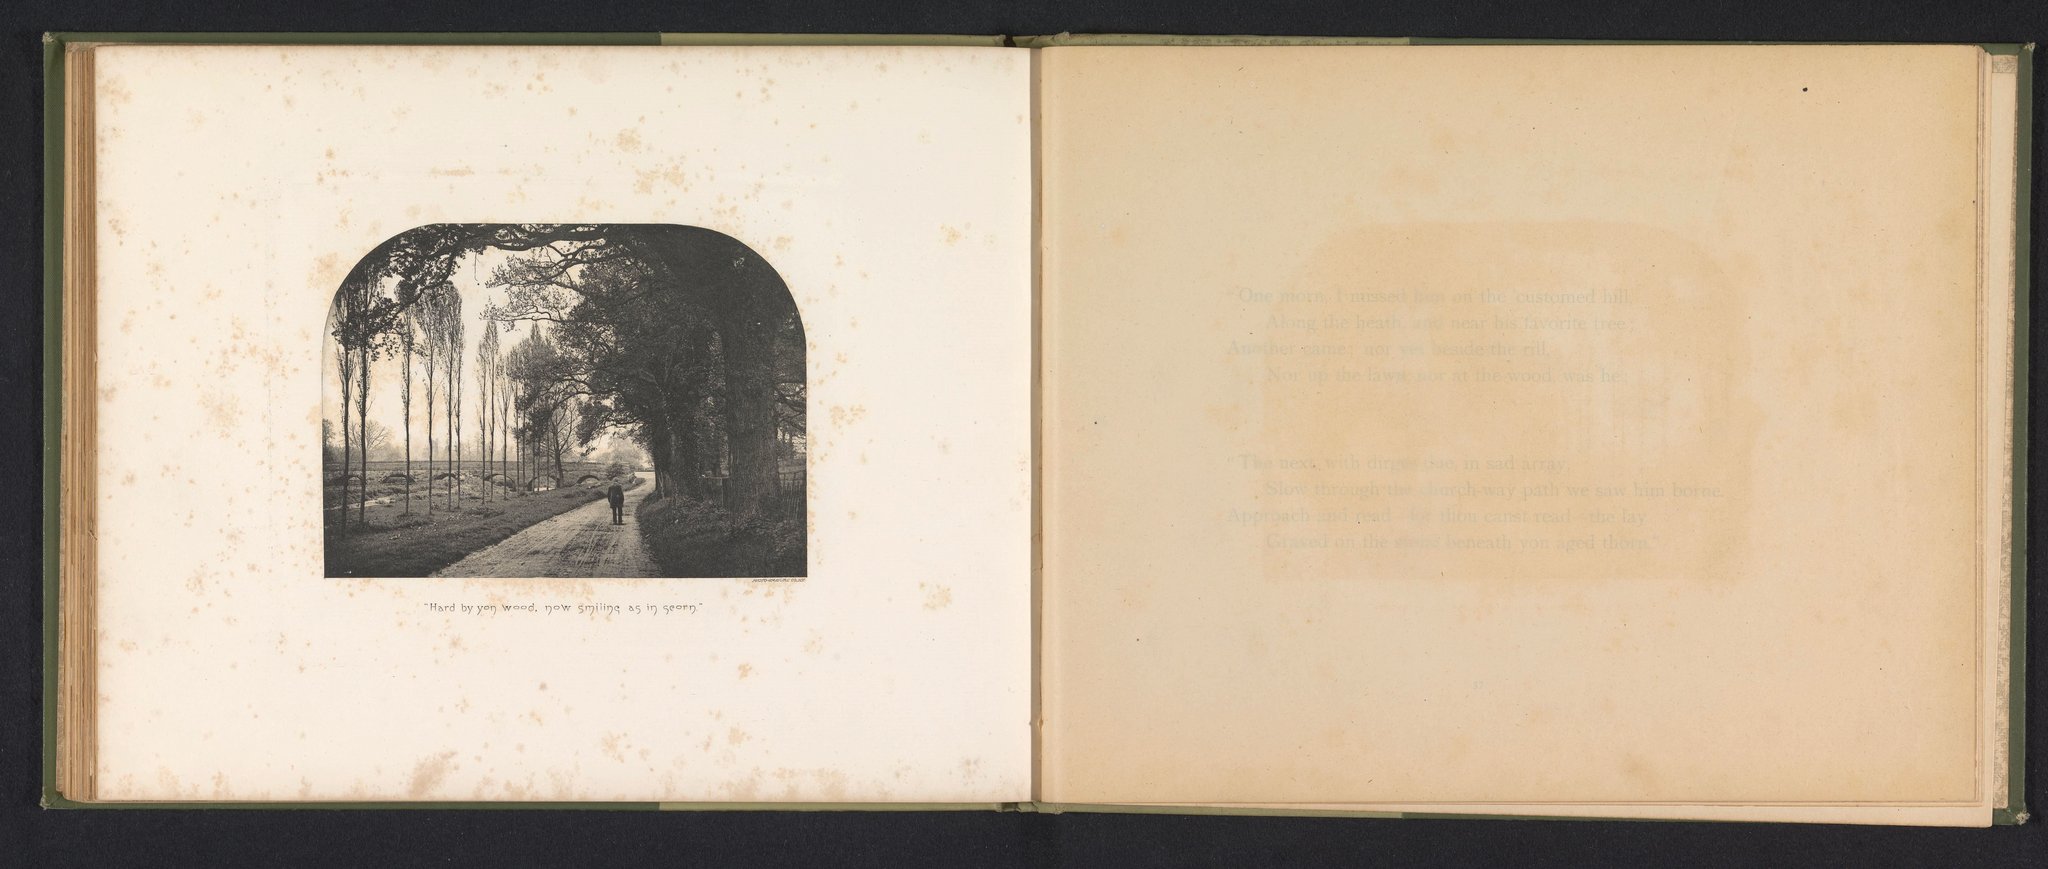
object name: page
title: Gezicht op iemand die op een landweg loopt met in de verte een brug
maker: james leon williams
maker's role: fotograaf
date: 1881-1891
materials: paper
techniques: photoaquatint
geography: england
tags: road, path, bridge, england